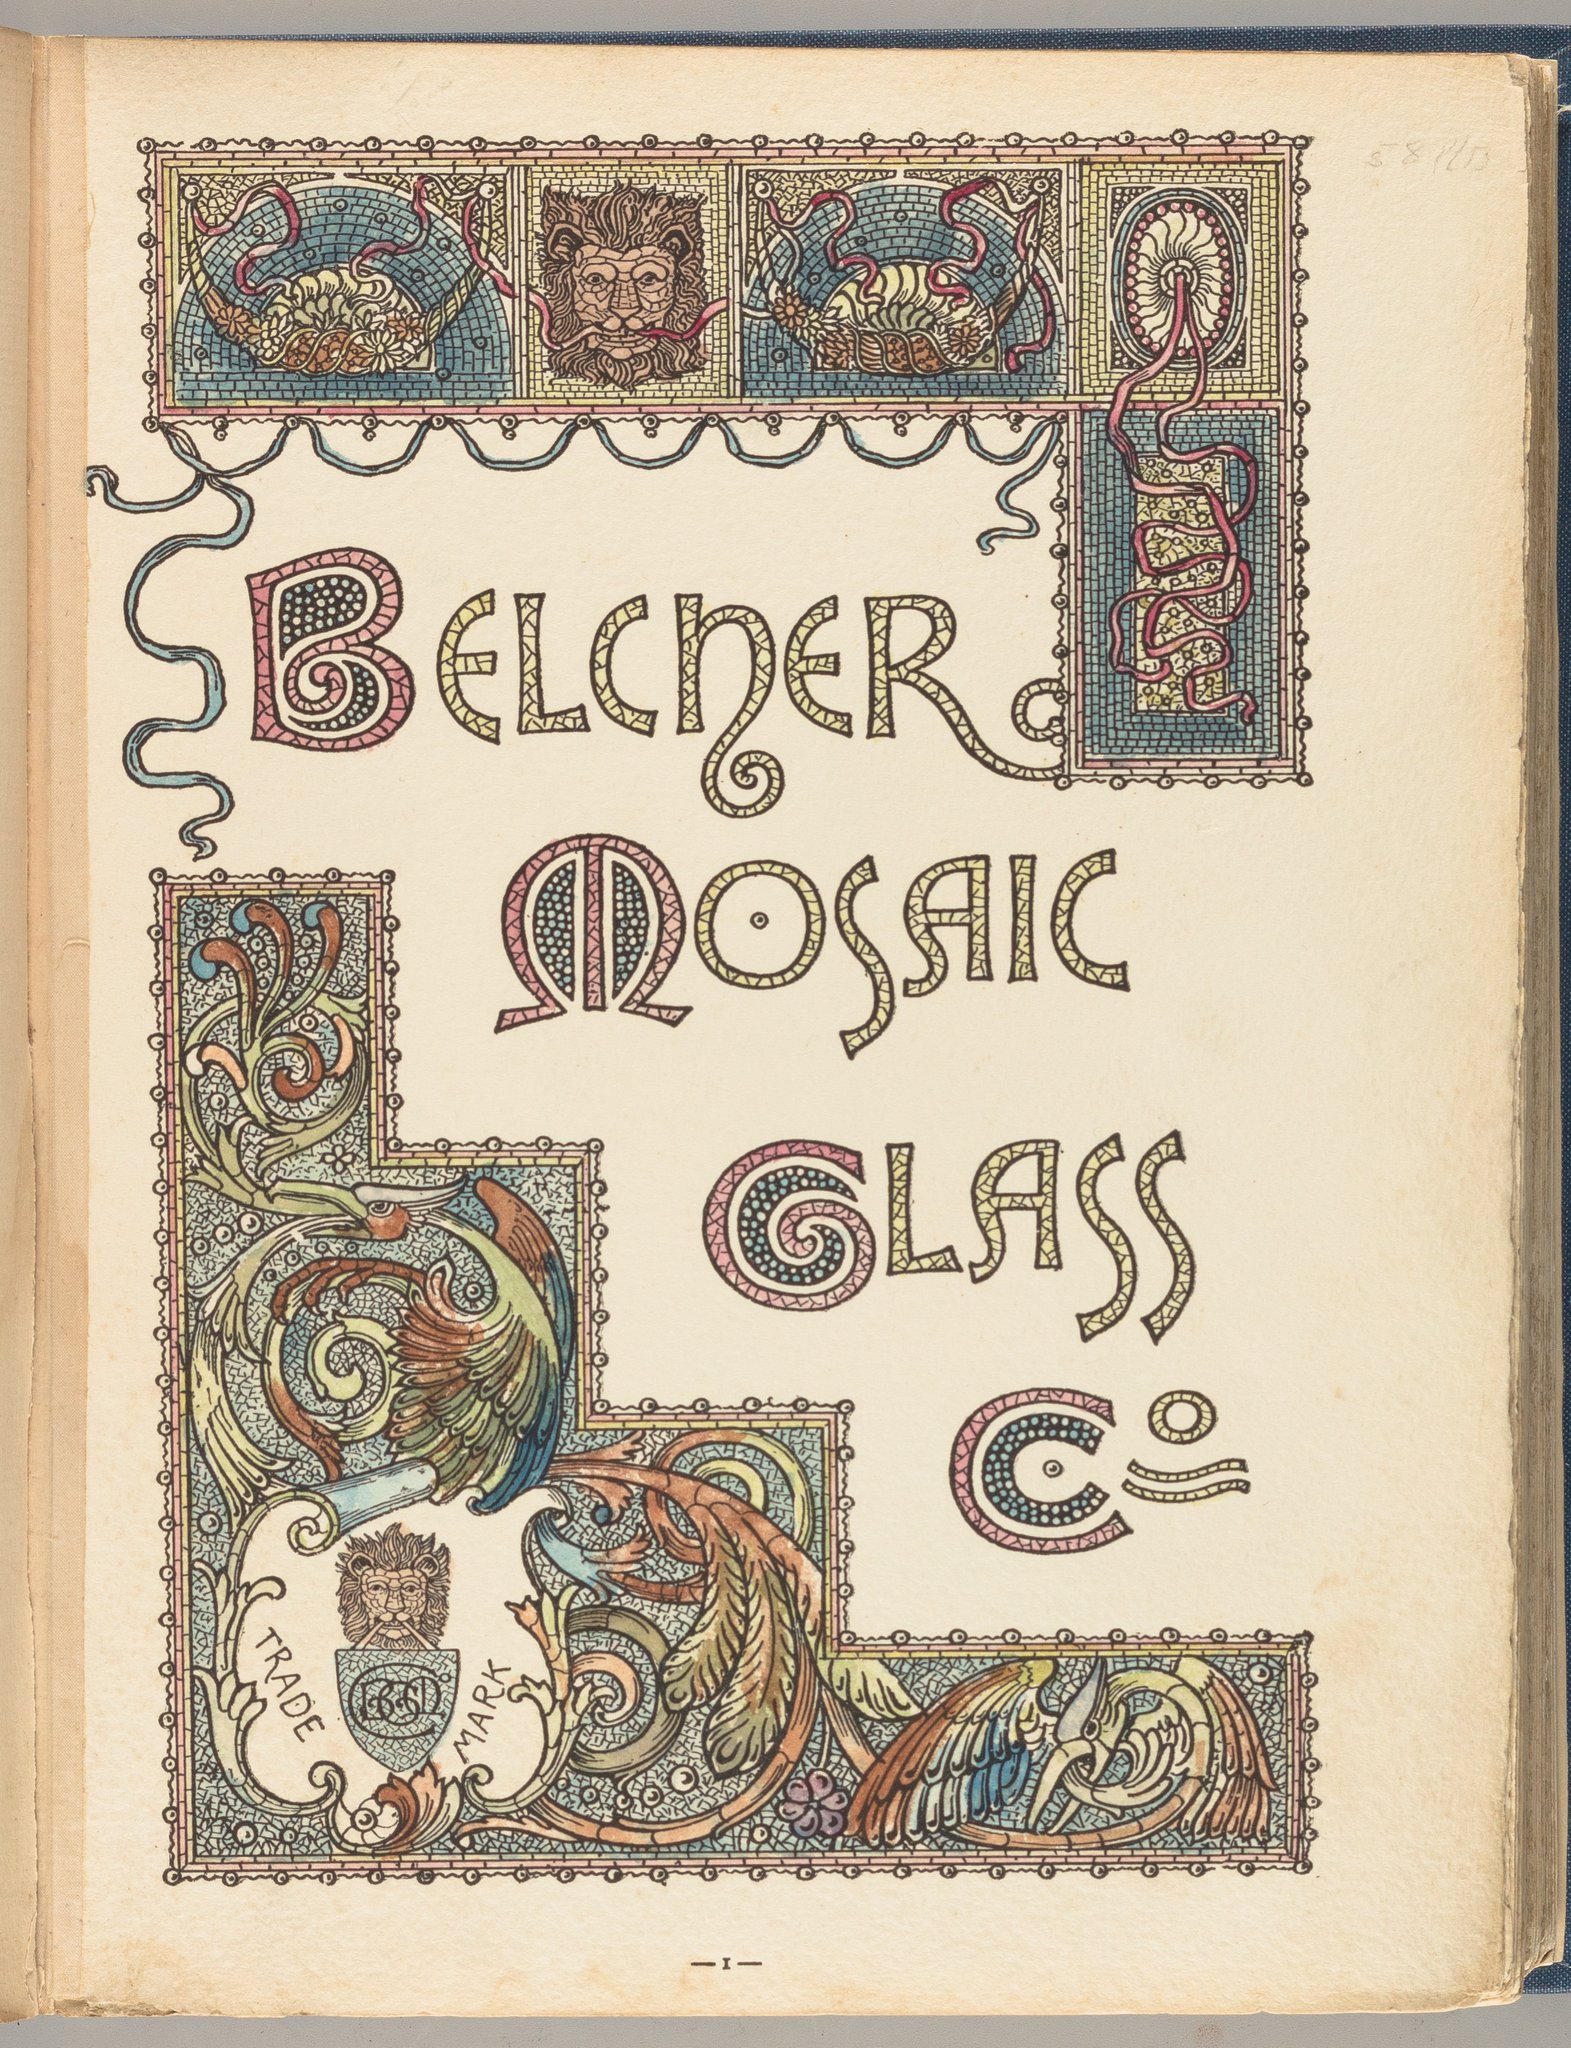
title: Belcher Mosaic Glass Co. : [catalog]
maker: belcher mosaic glass co.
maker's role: publisher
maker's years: 1825-1897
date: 1886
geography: newark